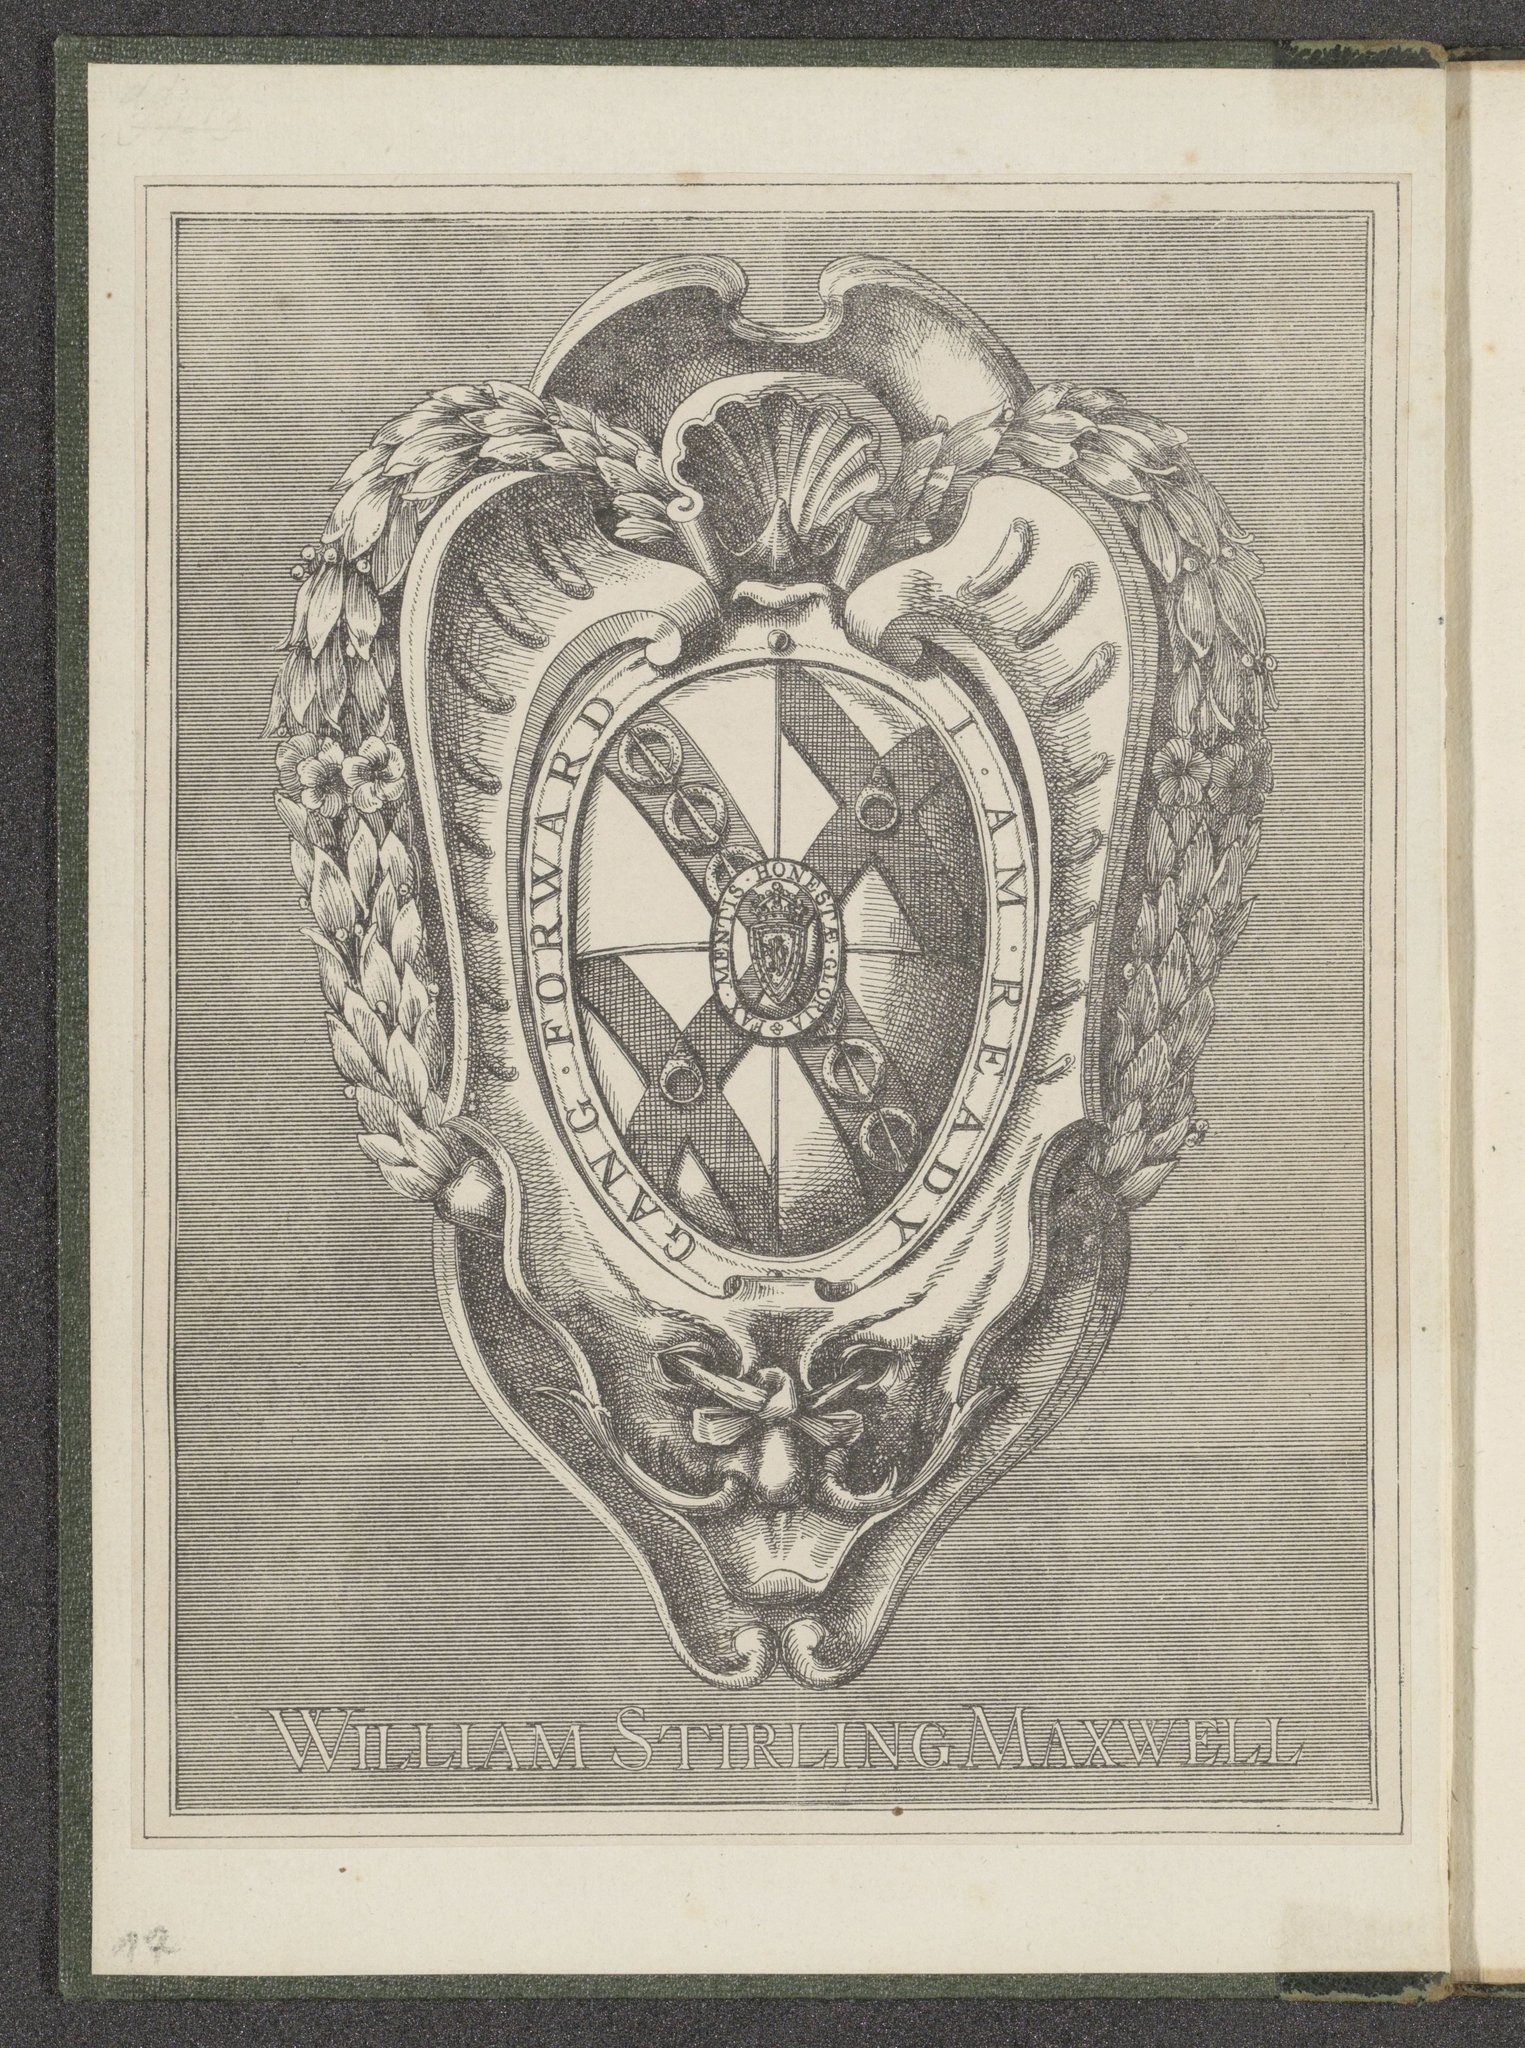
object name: pastedown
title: Ex libris van Sir William Stirling Maxwell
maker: Anonymous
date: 1838-1878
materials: paper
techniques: etching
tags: venice, politician, william stirling maxwell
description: Ex libris van boekverzamelaar Sir William Stirling Maxwell. Zijn wapenschild en zijn motto's gevat in een ornamenteel kader. Ex libris geplakt op dekblad. Deze prent maakt deel uit van een album.